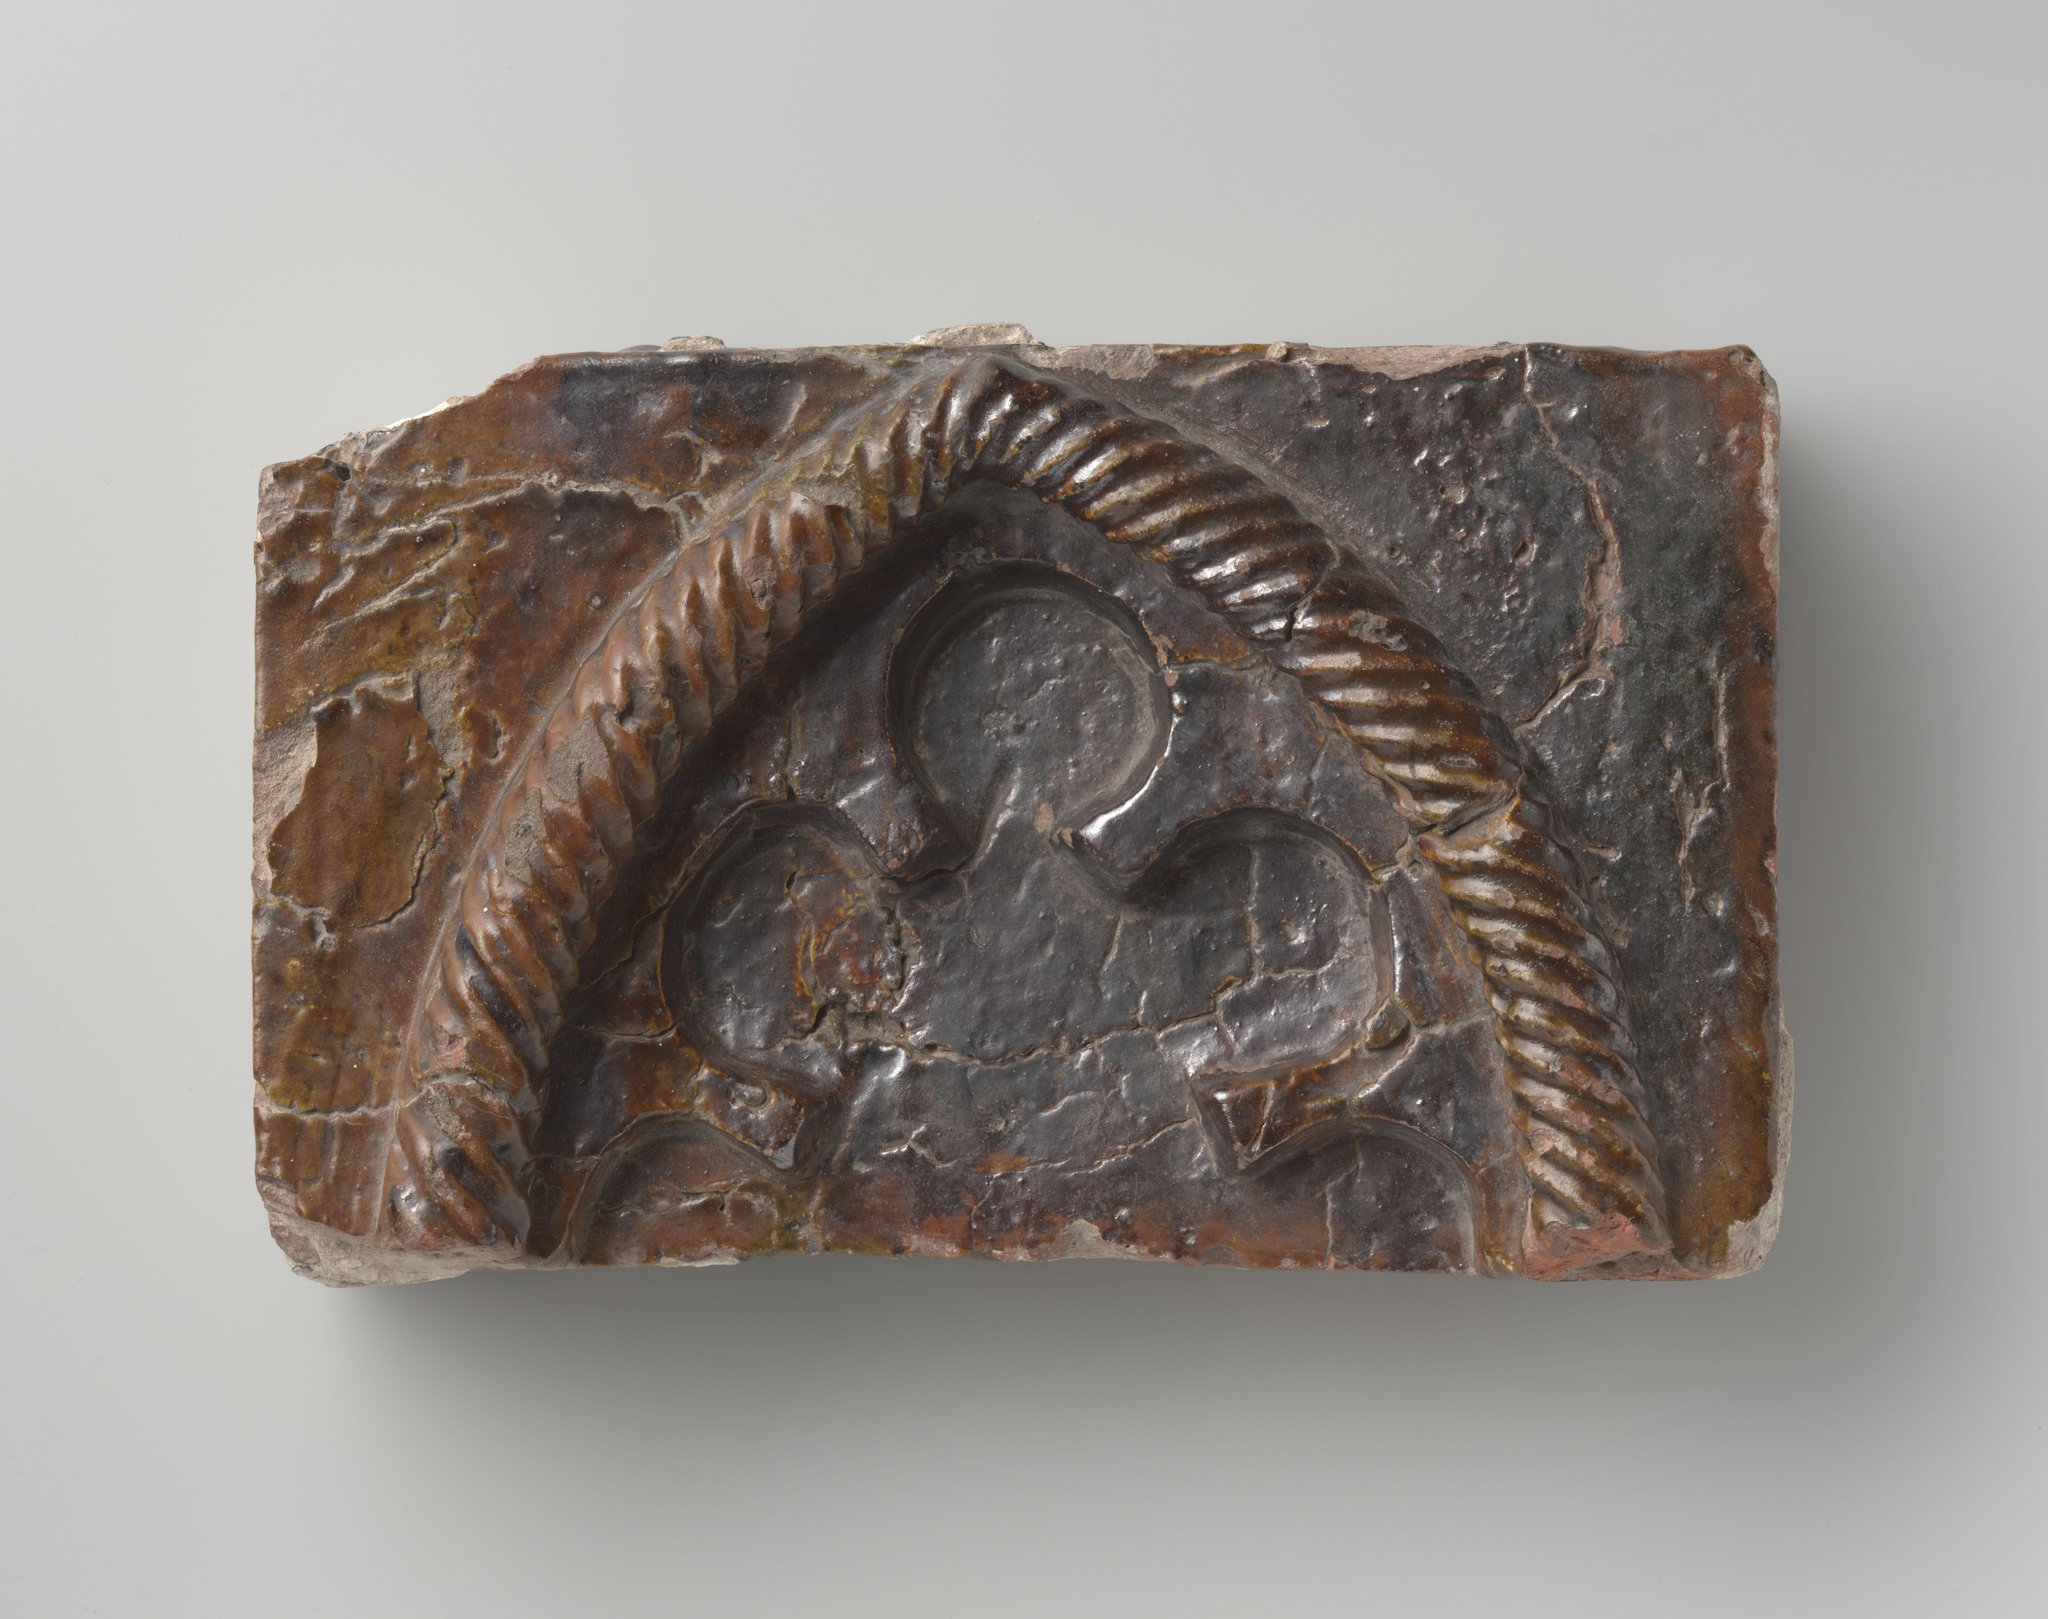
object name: brick clay product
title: Baksteen, afkomstig van de abdij te Aduard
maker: Anonymous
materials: brick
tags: aduard abbey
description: Een rechthoekige baksteen. In de steen verdiept aangebracht een driepastracering (navolging van een vensterraam), aan de zijkanten gevat tussen schuin geplaatst, elkander van boven met scherpe hoek ontmoetende koordmotieven in reliëf. Bovenkant geheel bedekt met loodglazuur, ongelijk van tint, varierend tussen goudbruin en donkerbruin, waarin sporen van groen. Afkomstig van de Abdij te Aduard.